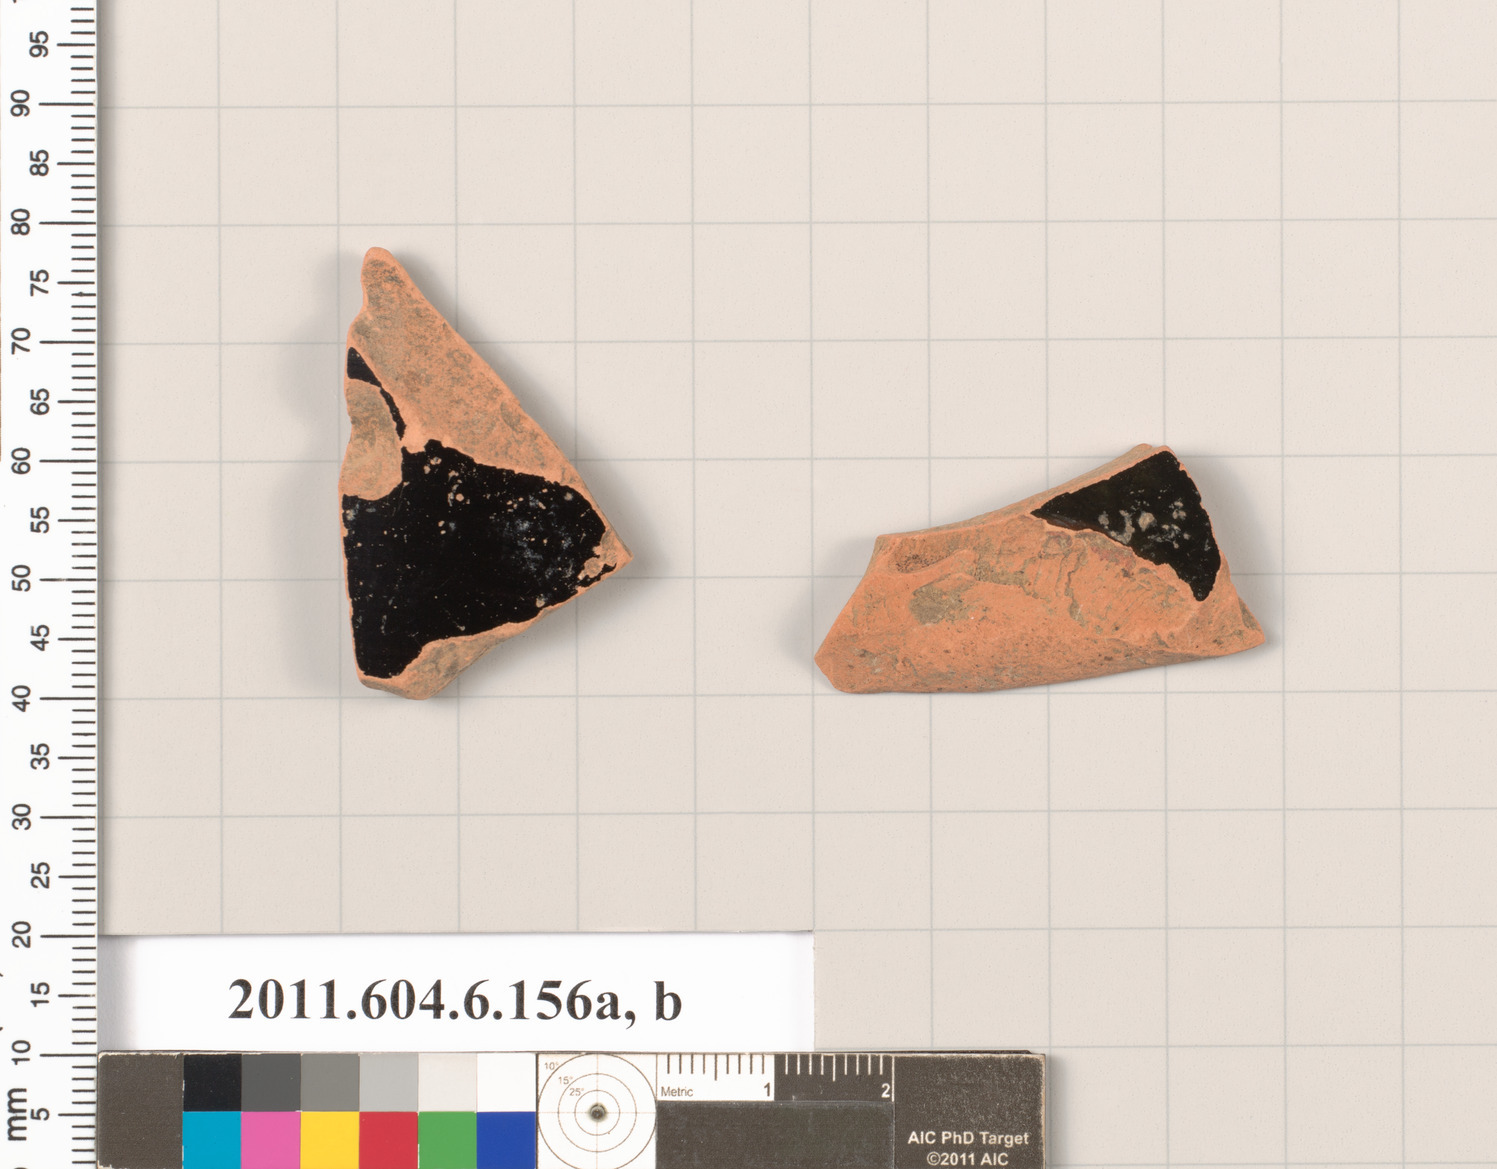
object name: undetermined open shape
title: Terracotta fragments of open shapes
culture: greek, attic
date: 600-401 BCE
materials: terracotta